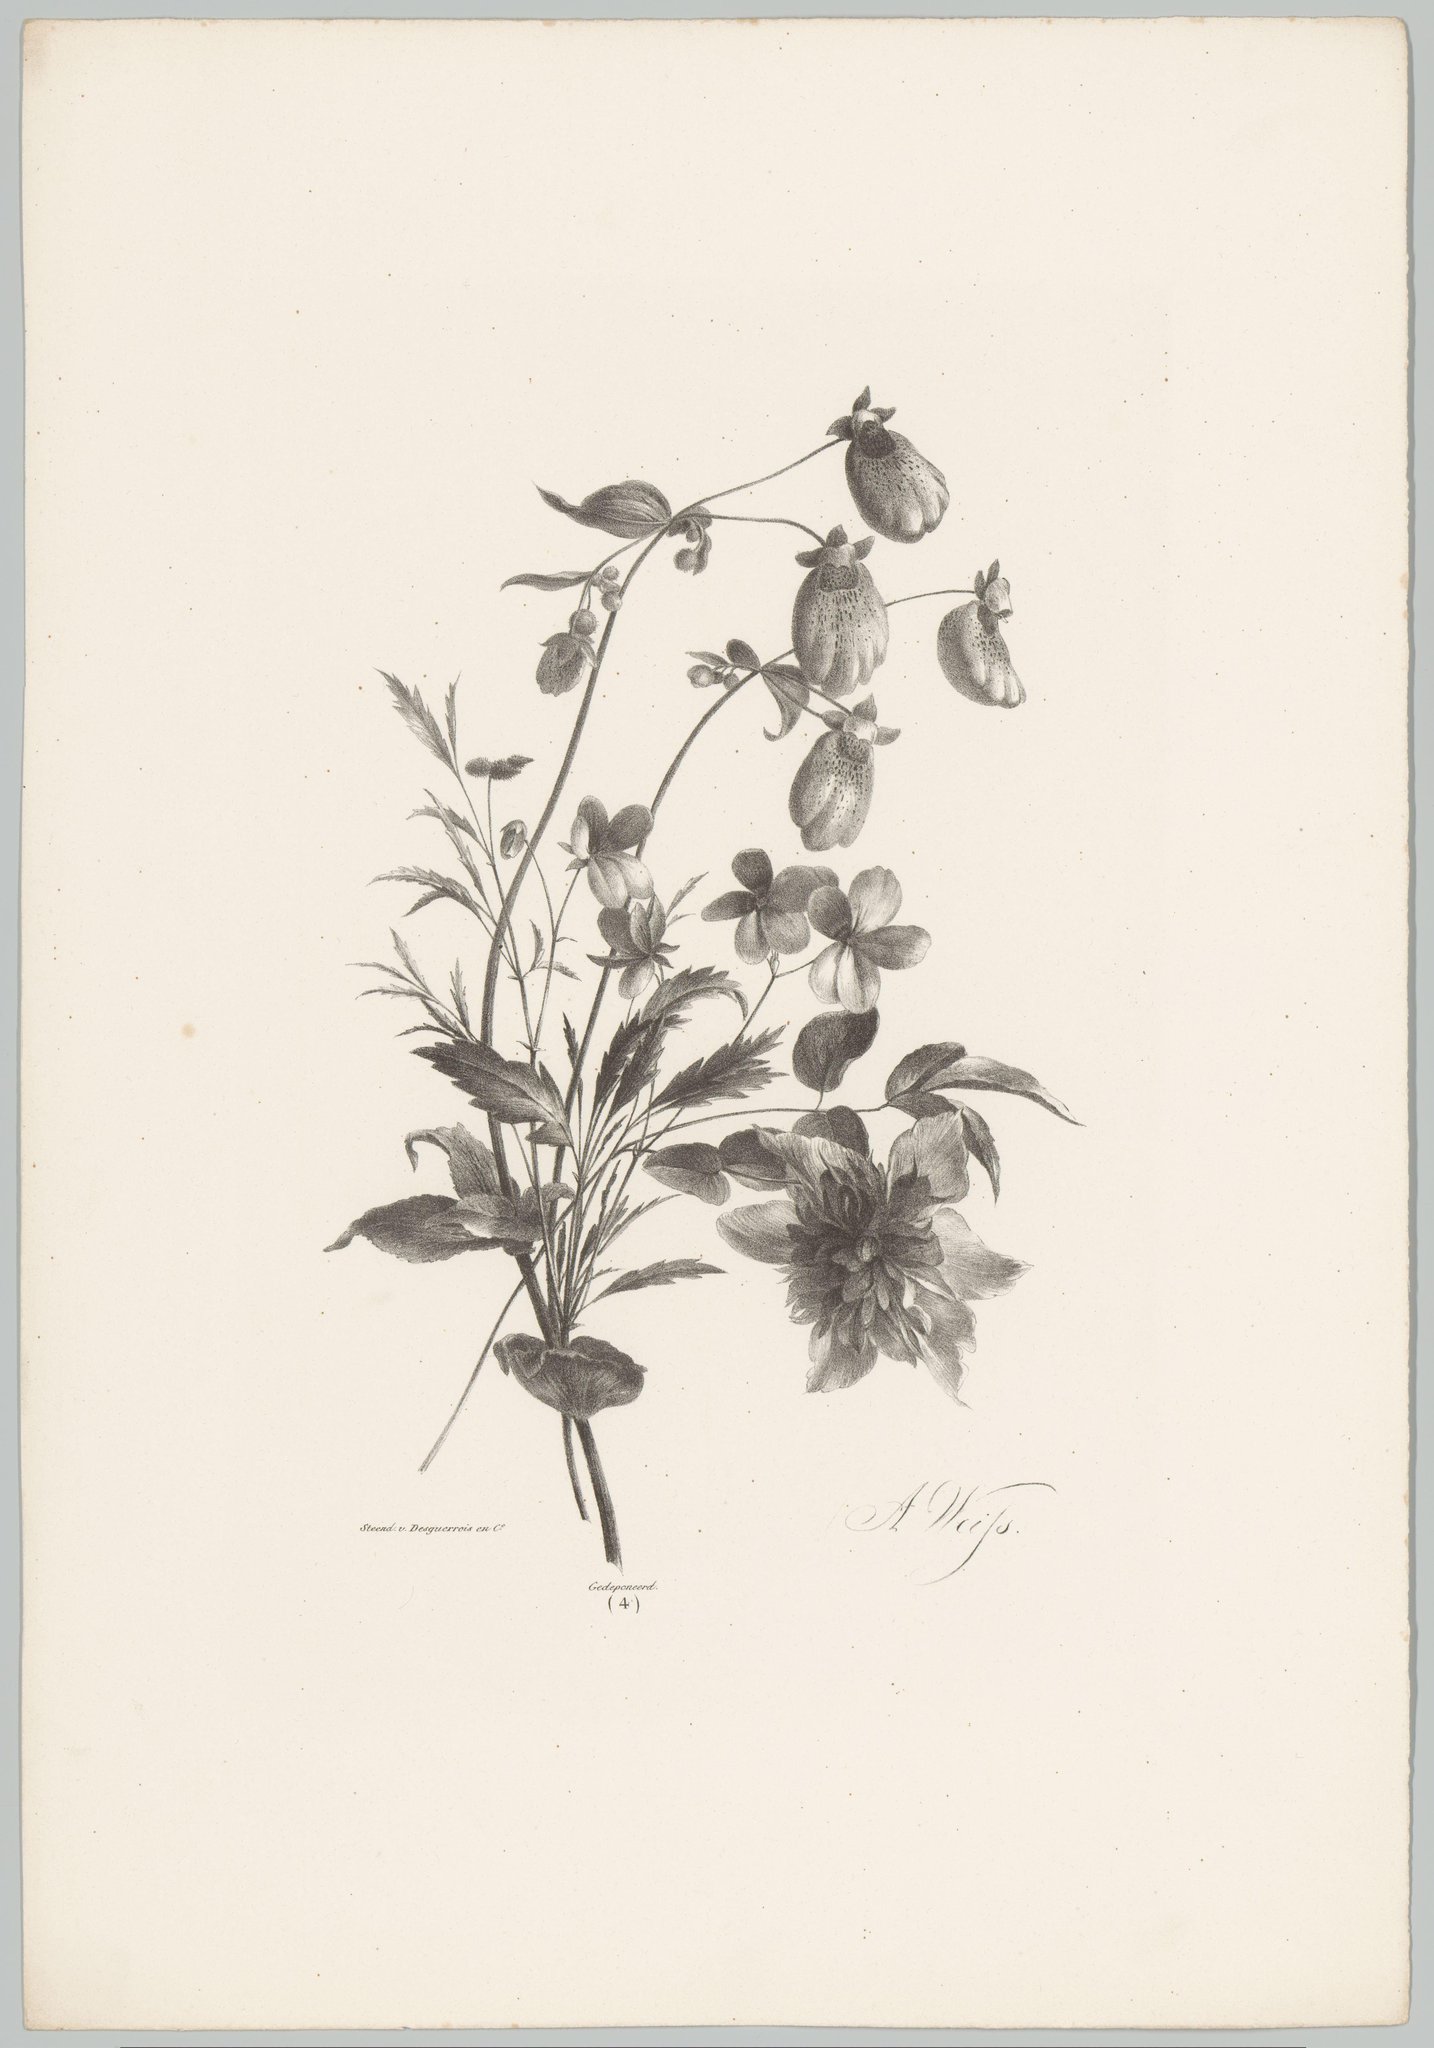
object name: print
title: Bloem en Fruit Studien (...) 10e aflevering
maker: anton weiss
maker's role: draughtsman, print maker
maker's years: 1801-1851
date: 1836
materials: paper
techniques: lithograph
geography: amsterdam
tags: flowers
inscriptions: collector's mark: Lugt 2228, : ‘Gedeponeerd.’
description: Onderdeel van een omslag met een serie van eenenveertig lithografieën van bloemen en fruit.